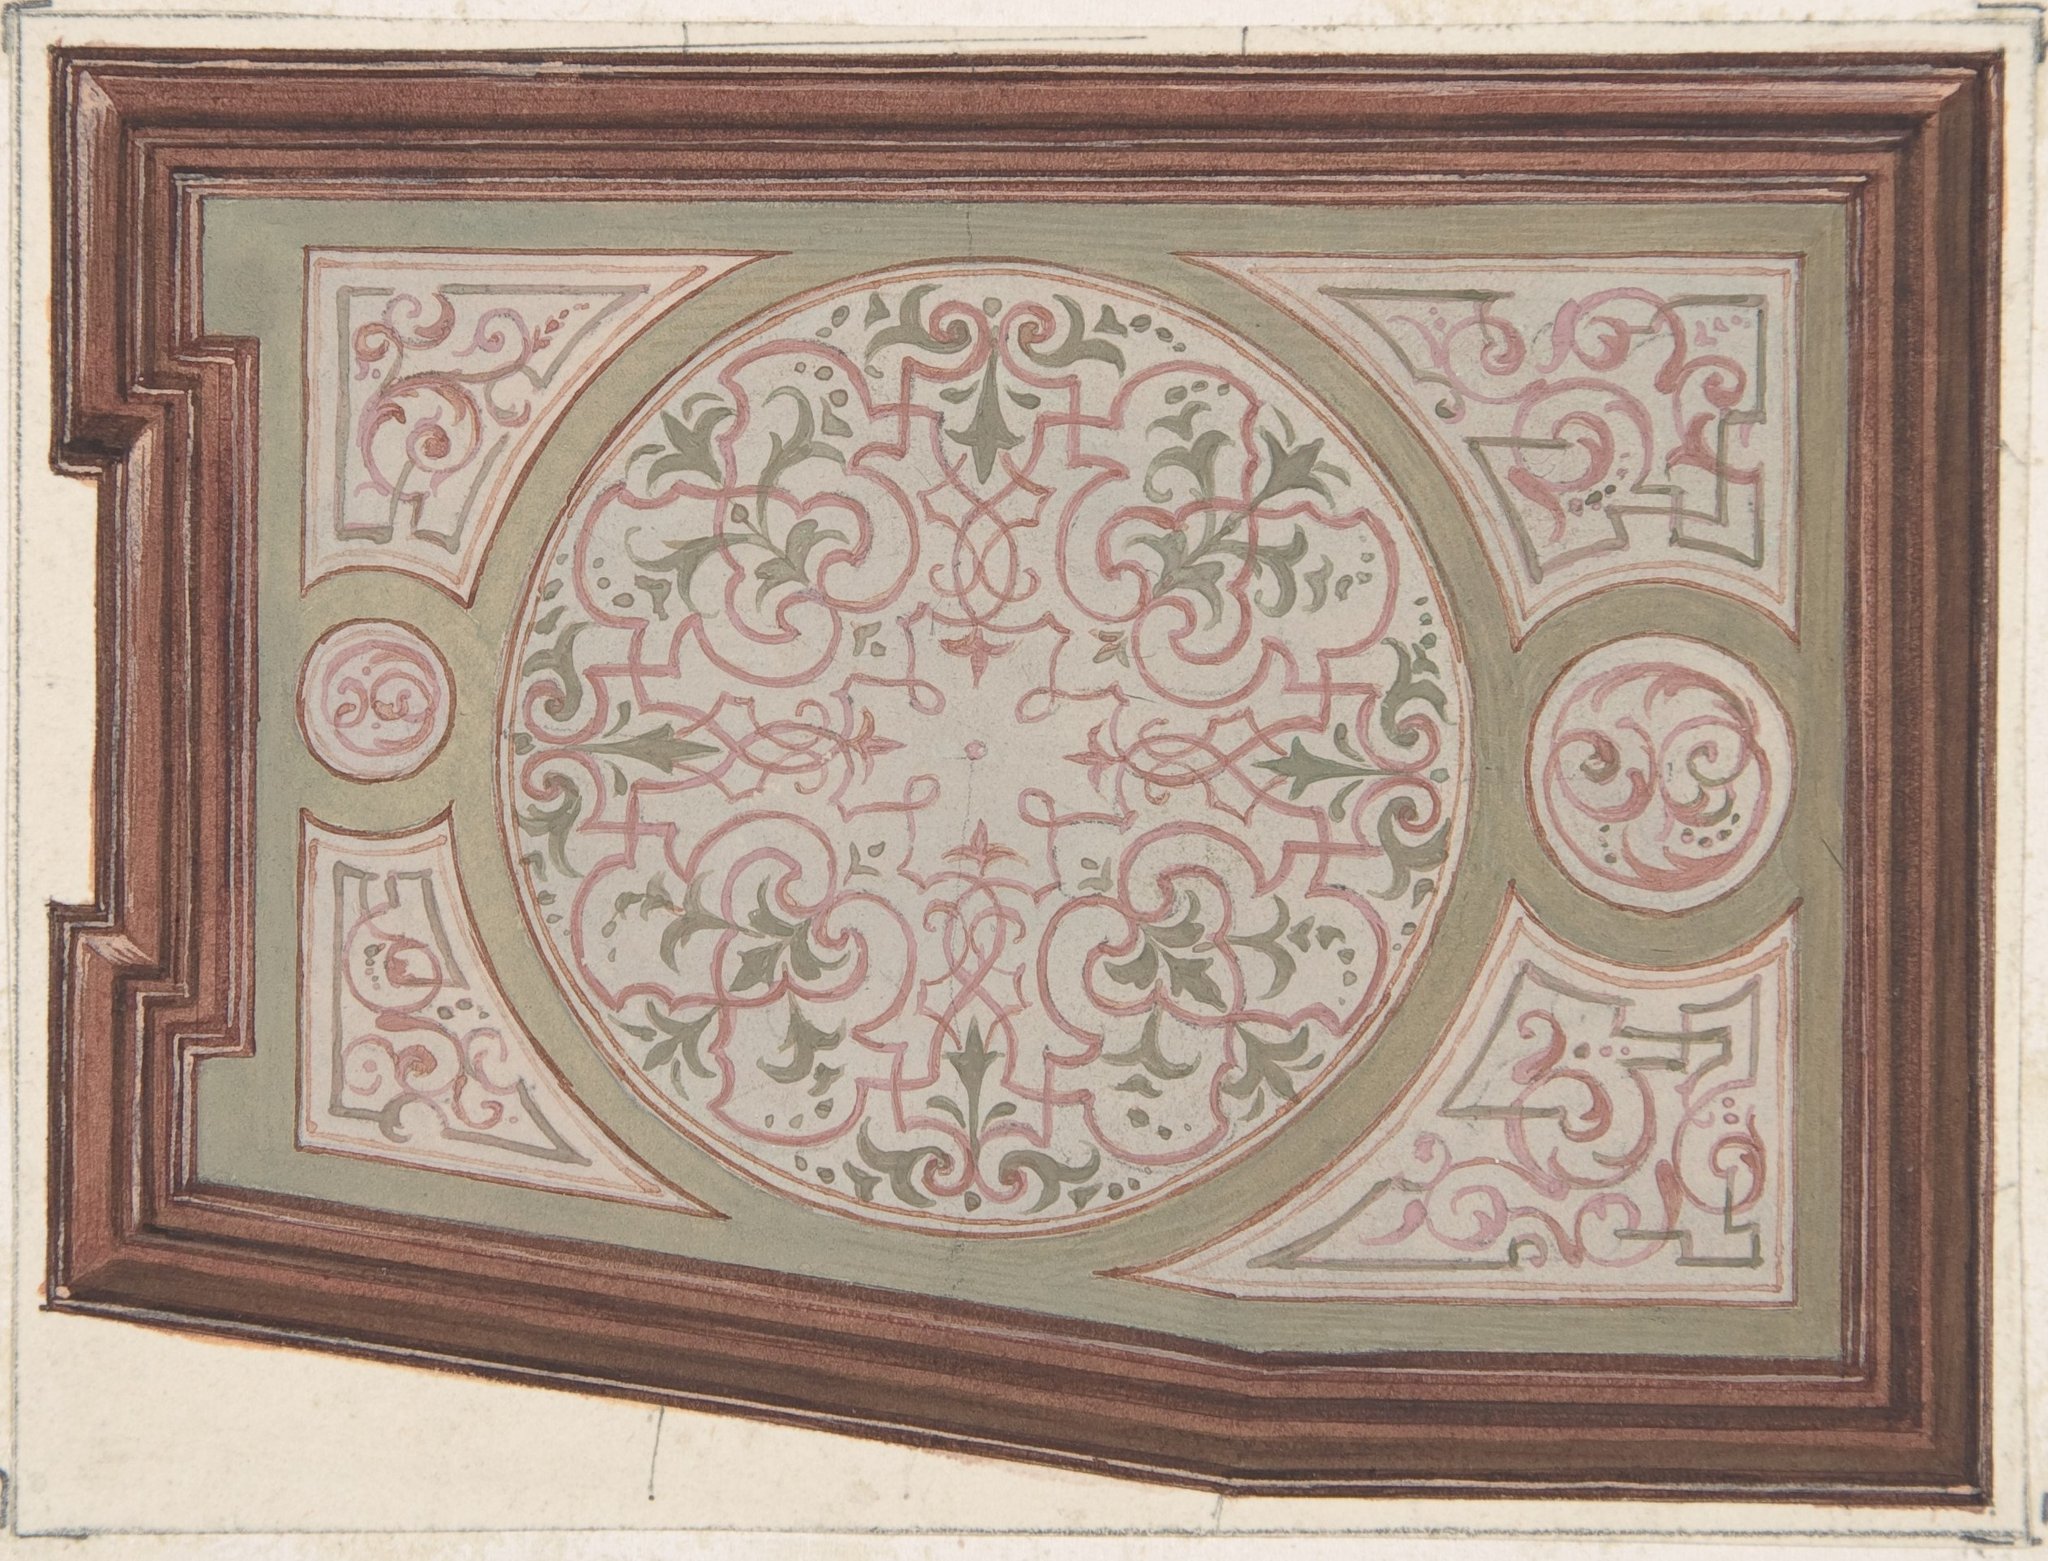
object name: drawing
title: Design for Ceiling, Hôtel Hope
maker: jules-edmond-charles lachaise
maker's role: artist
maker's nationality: french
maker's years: 1897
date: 1867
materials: gouache, watercolor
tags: ceilings